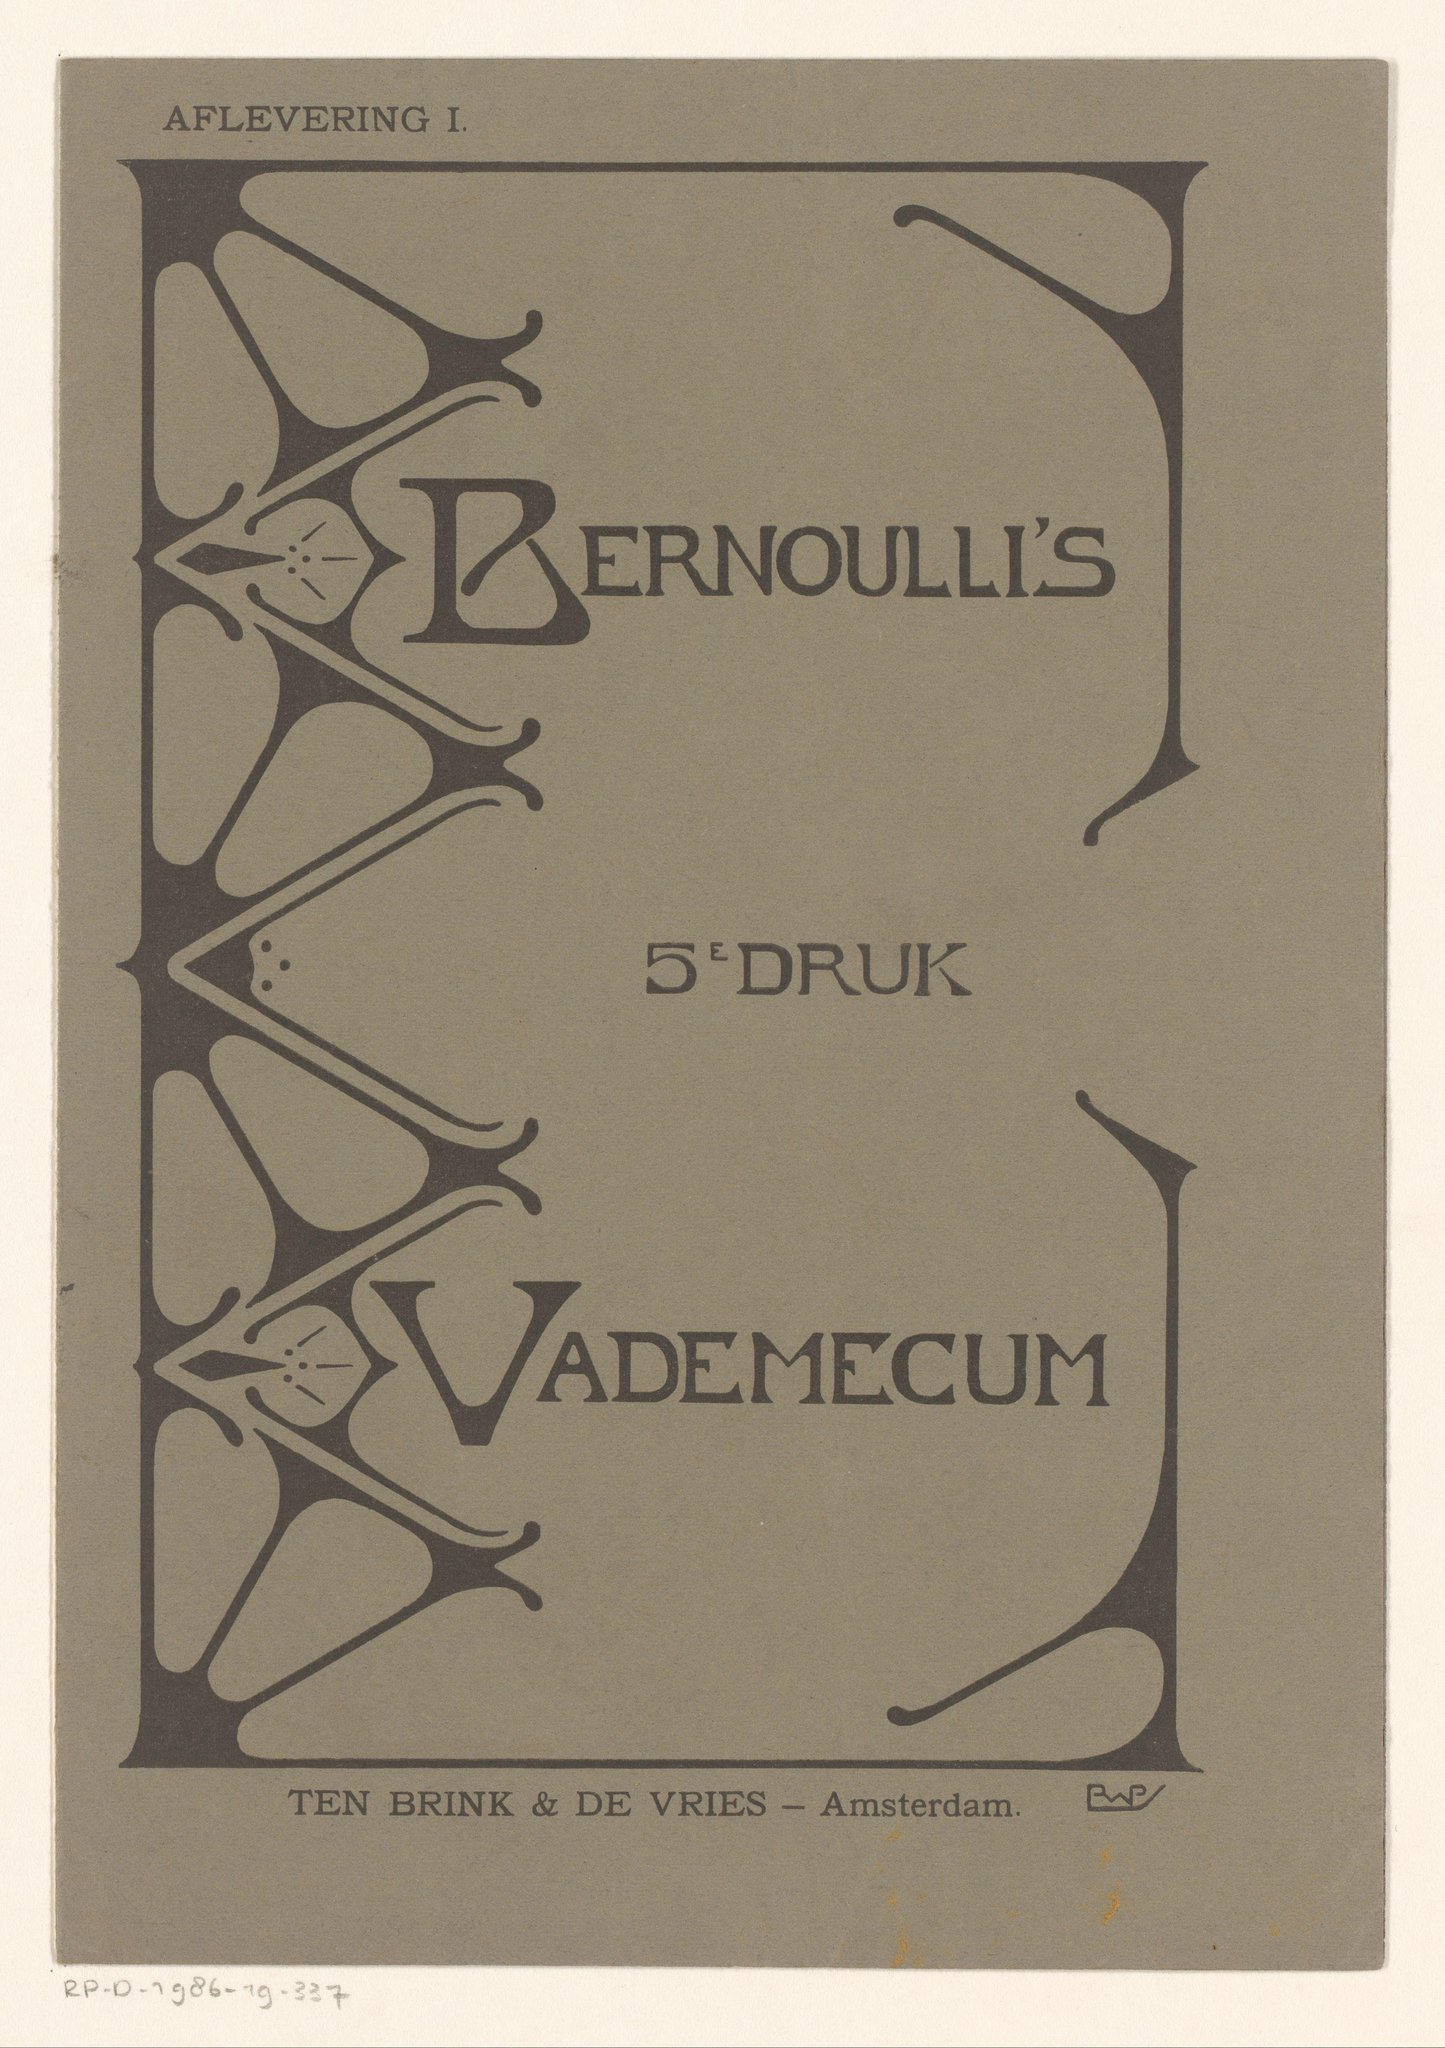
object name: wrapper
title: Omslag van: Bernoulli's Vademecum, 1902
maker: reinier willem petrus de vries (1874-1953)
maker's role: draughtsman, print maker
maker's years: 1874-1953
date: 1902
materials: paper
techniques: printing block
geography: amsterdam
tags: ornament ~ geometric motifs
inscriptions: collector's mark: ‘R:MVS.’